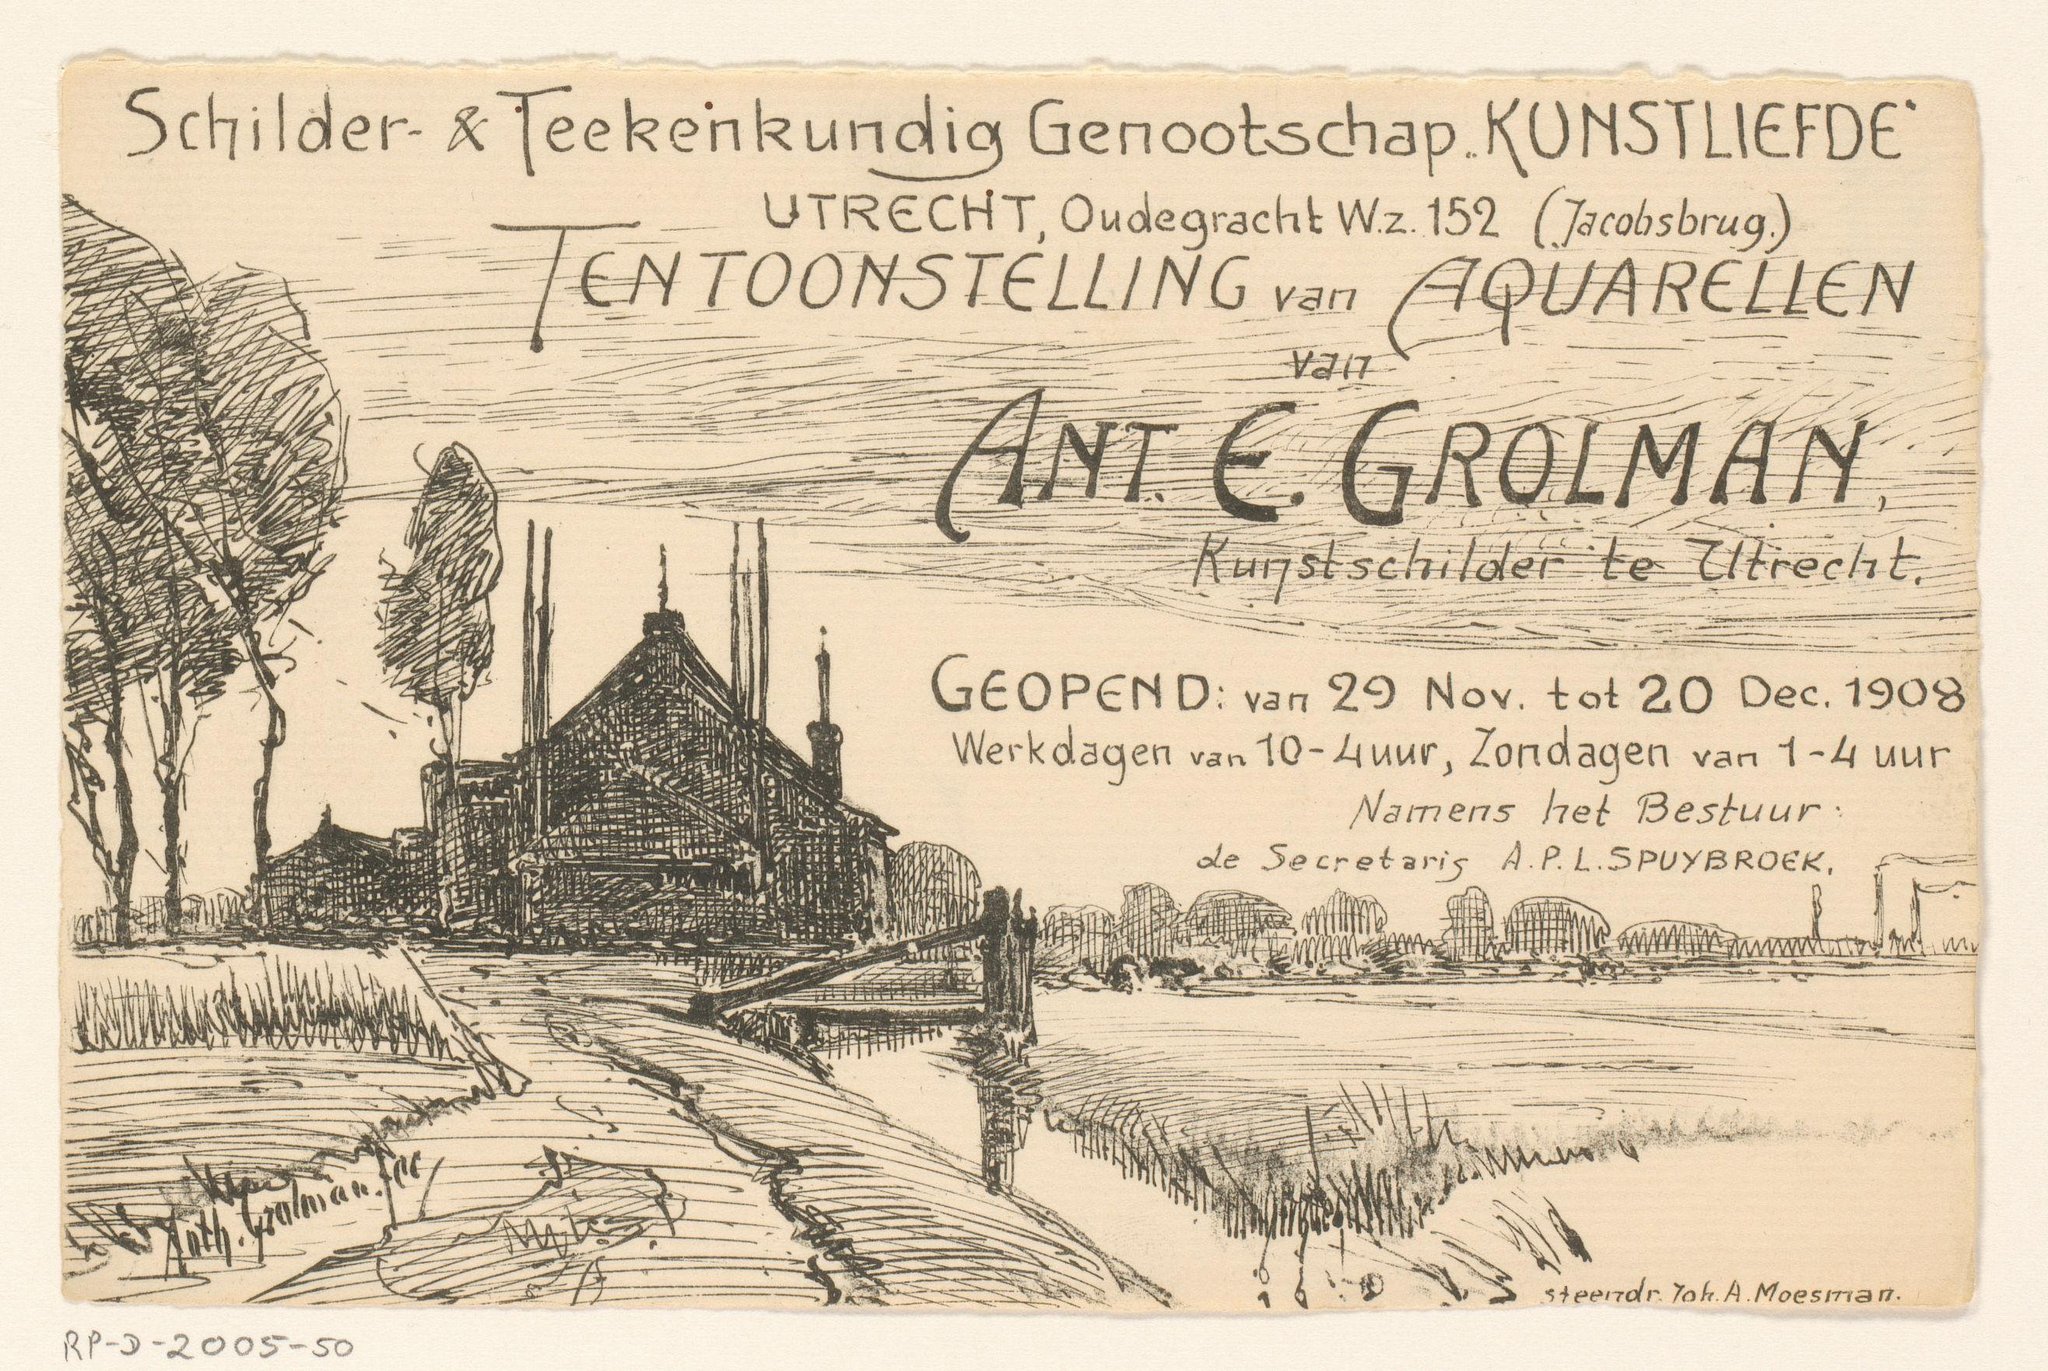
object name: invitation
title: Uitnodiging van Schilder- en Teekenkundig Genootschap "Kunstliefde" voor een tentoonstelling van het werk van Anthony Grolman, 29 november - 20 december 1908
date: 1908-1911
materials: paper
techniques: lithograph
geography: utrecht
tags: utrecht, draughtsman, anthony grolman, criticizing and discussing art, art criticism, circle, club of artists, collecting and exhibiting products of the fine arts, farm or solitary house in landscape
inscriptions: collector's mark: Lugt 2228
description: Landschap met boerderij. Uitnodiging van Schilder- en Teekenkundig Genootschap "Kunstliefde" voor een tentoonstelling van aquarellen van Anthony Grolman, kunstschilder te Utrecht, 29 november - 20 december 1908.